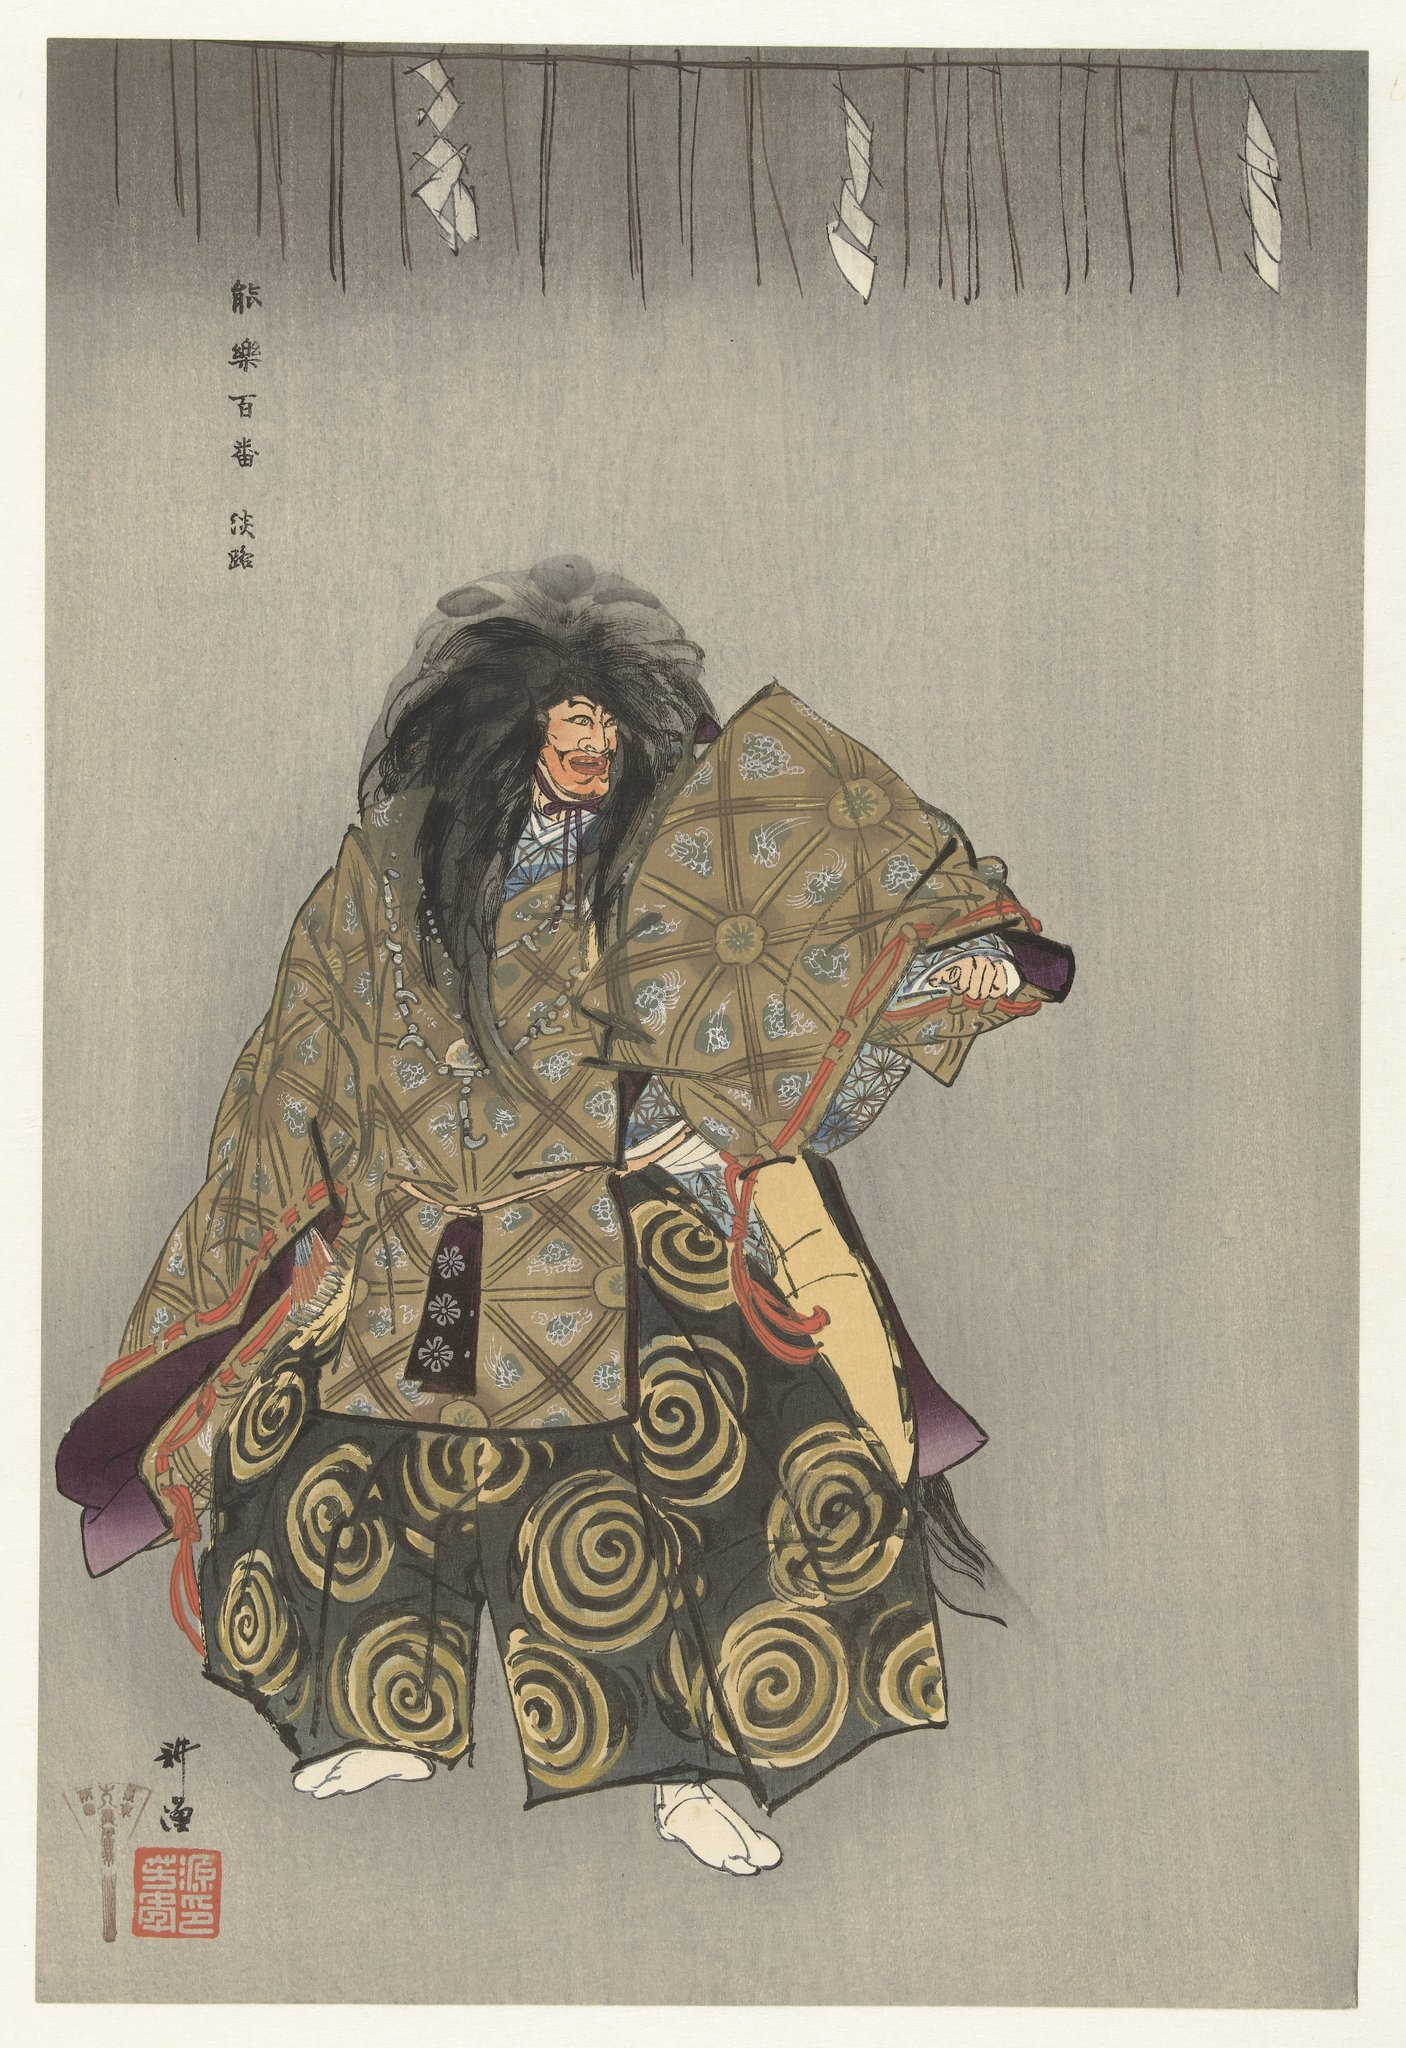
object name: print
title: Scene from the No Play Awaji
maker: tsukioka kôgyo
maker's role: print maker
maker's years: 1869-1927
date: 1907-1926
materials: paper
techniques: woodcut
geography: japan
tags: actor (on the stage)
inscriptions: collector's mark: Lugt 2228, collector's mark: Lugt 2760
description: The deity Izanagi appears on stage in the play Awaji. He and the female deity Izanami set foot on the island of Awaji, as the creators of the Japanese island empire. In the play he dances to laud Japan’s prosperity. He wears the short jacket of a court nobleman (kariginu). An example of this type of jacket is on view in the opposite display case.